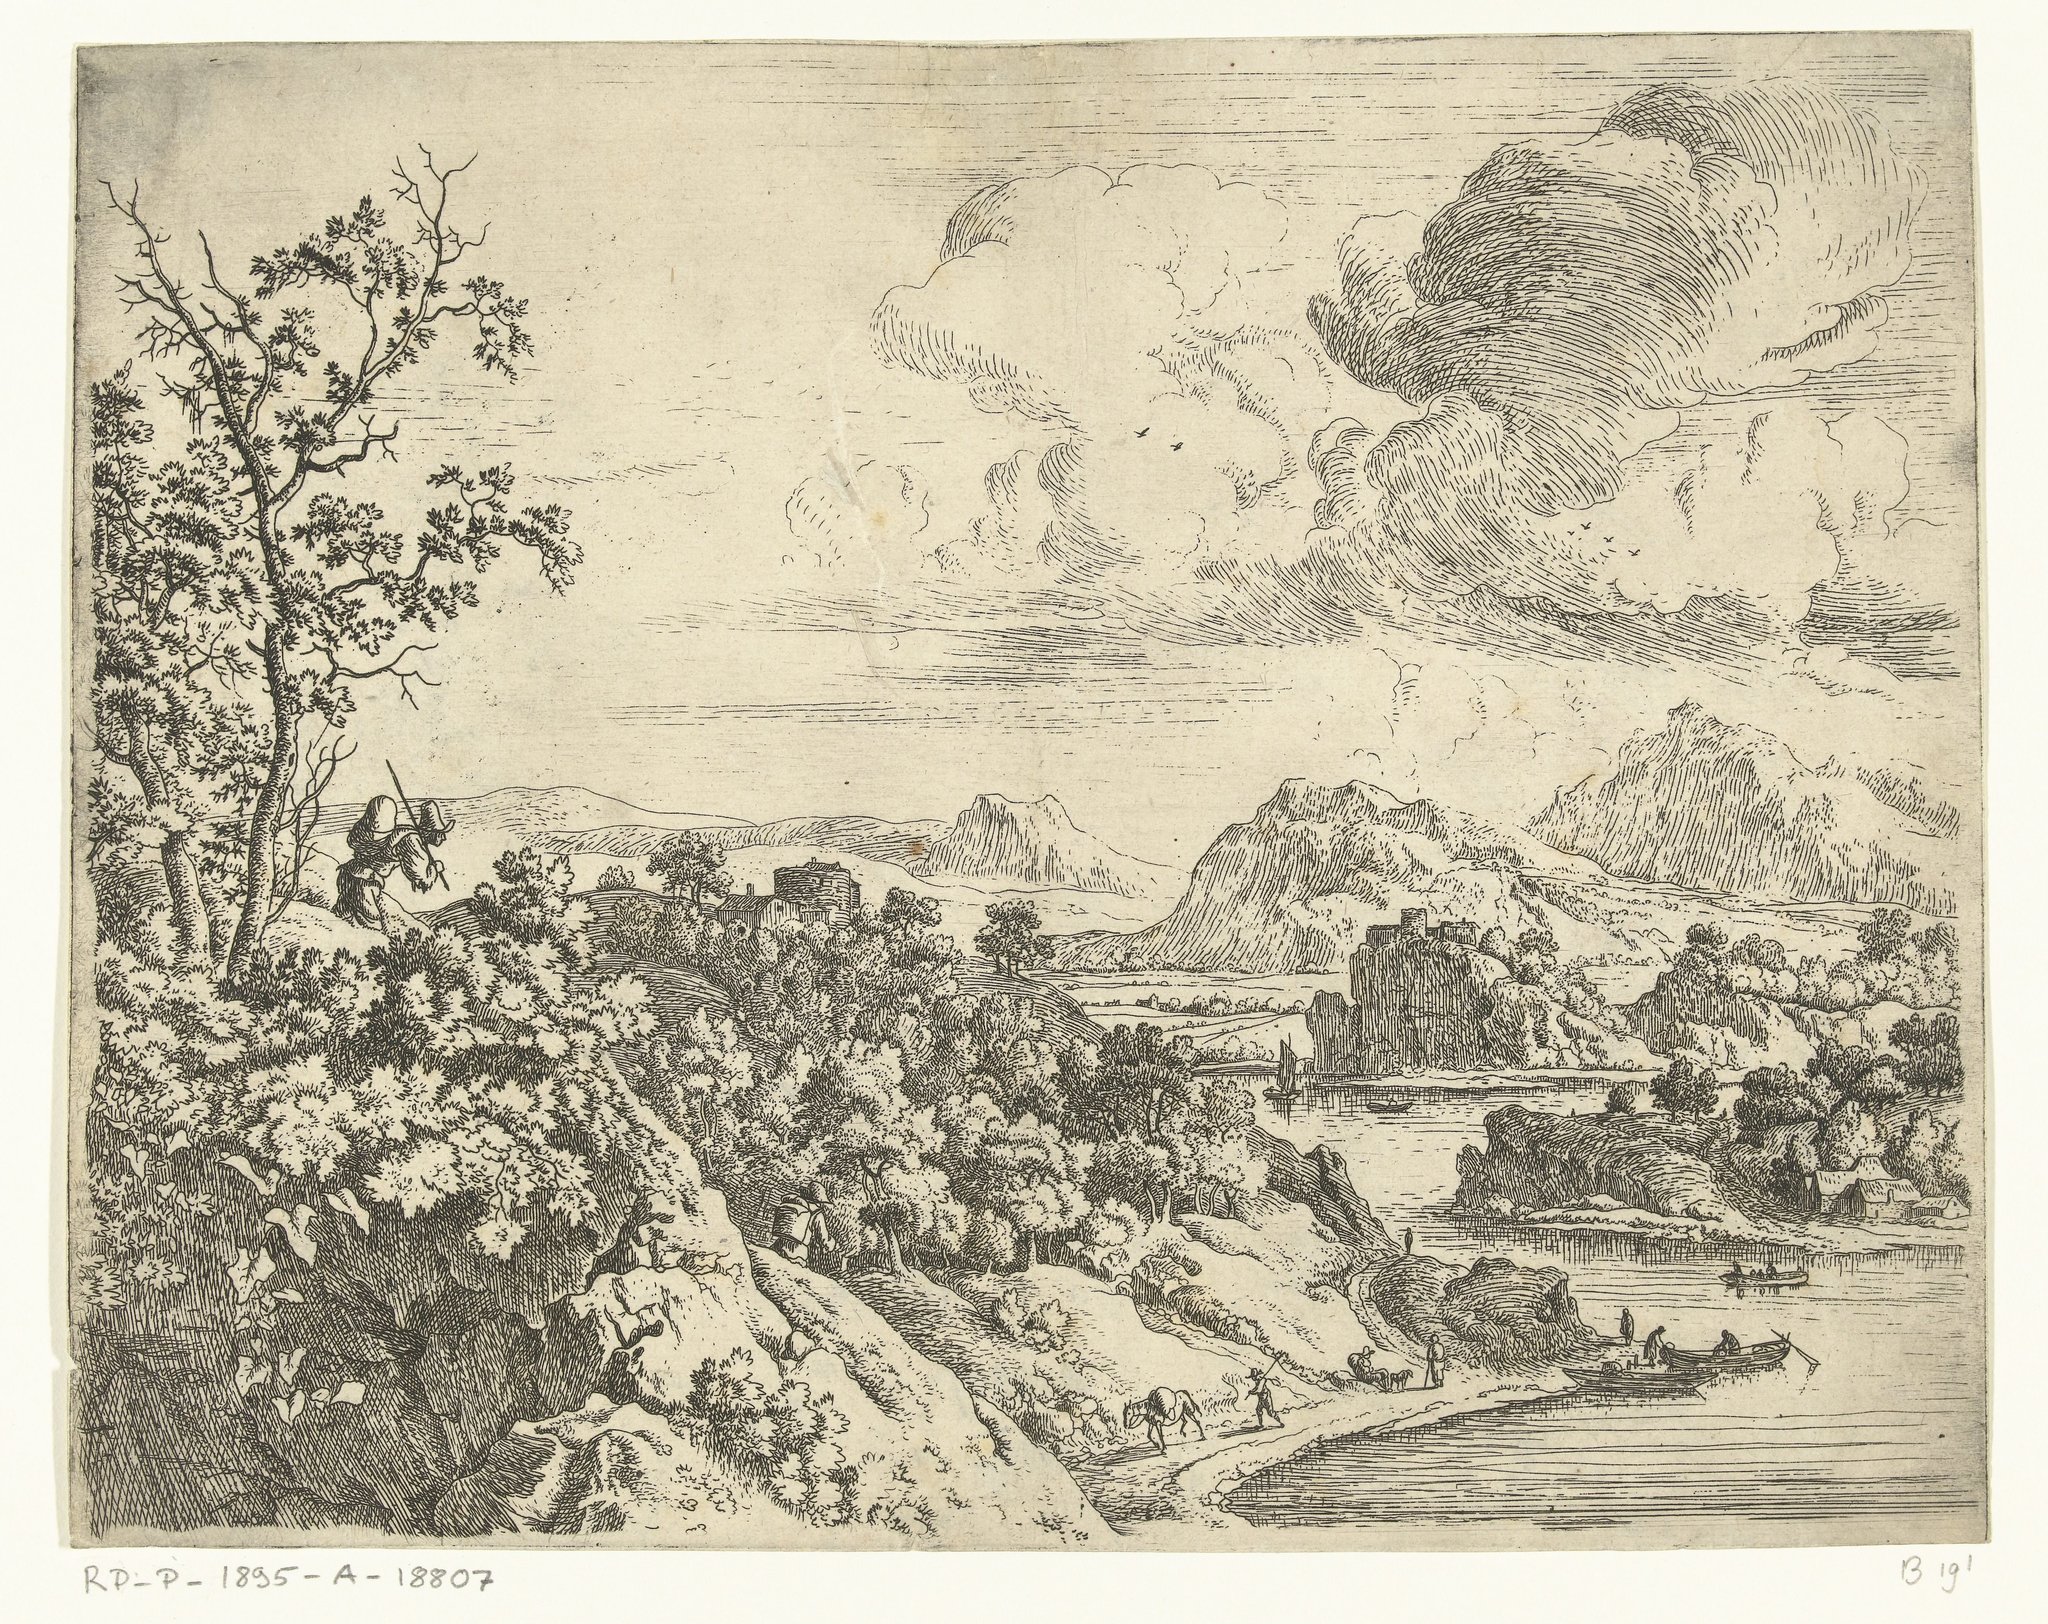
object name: print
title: Rivierlandschap met man met pak op zijn rug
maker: jan van aken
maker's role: draughtsman, print maker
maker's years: 1614-1661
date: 1624-1661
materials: paper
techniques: etching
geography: netherlands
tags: landscapes with waters, waterscapes, seascapes (in the temperate zone)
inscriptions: collector's mark: Lugt 2228